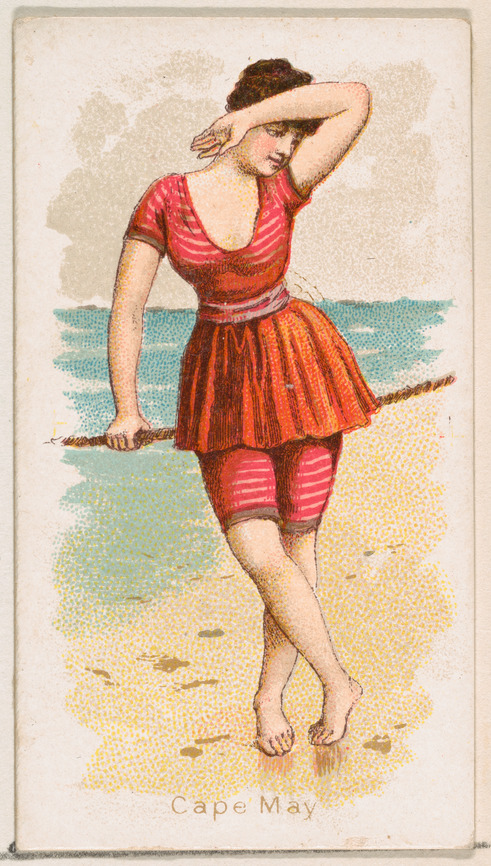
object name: print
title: Cape May, from the Fancy Bathers series (N187) issued by Wm. S. Kimball & Co.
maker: william s. kimball & company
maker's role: publisher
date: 1889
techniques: color lithograph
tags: women